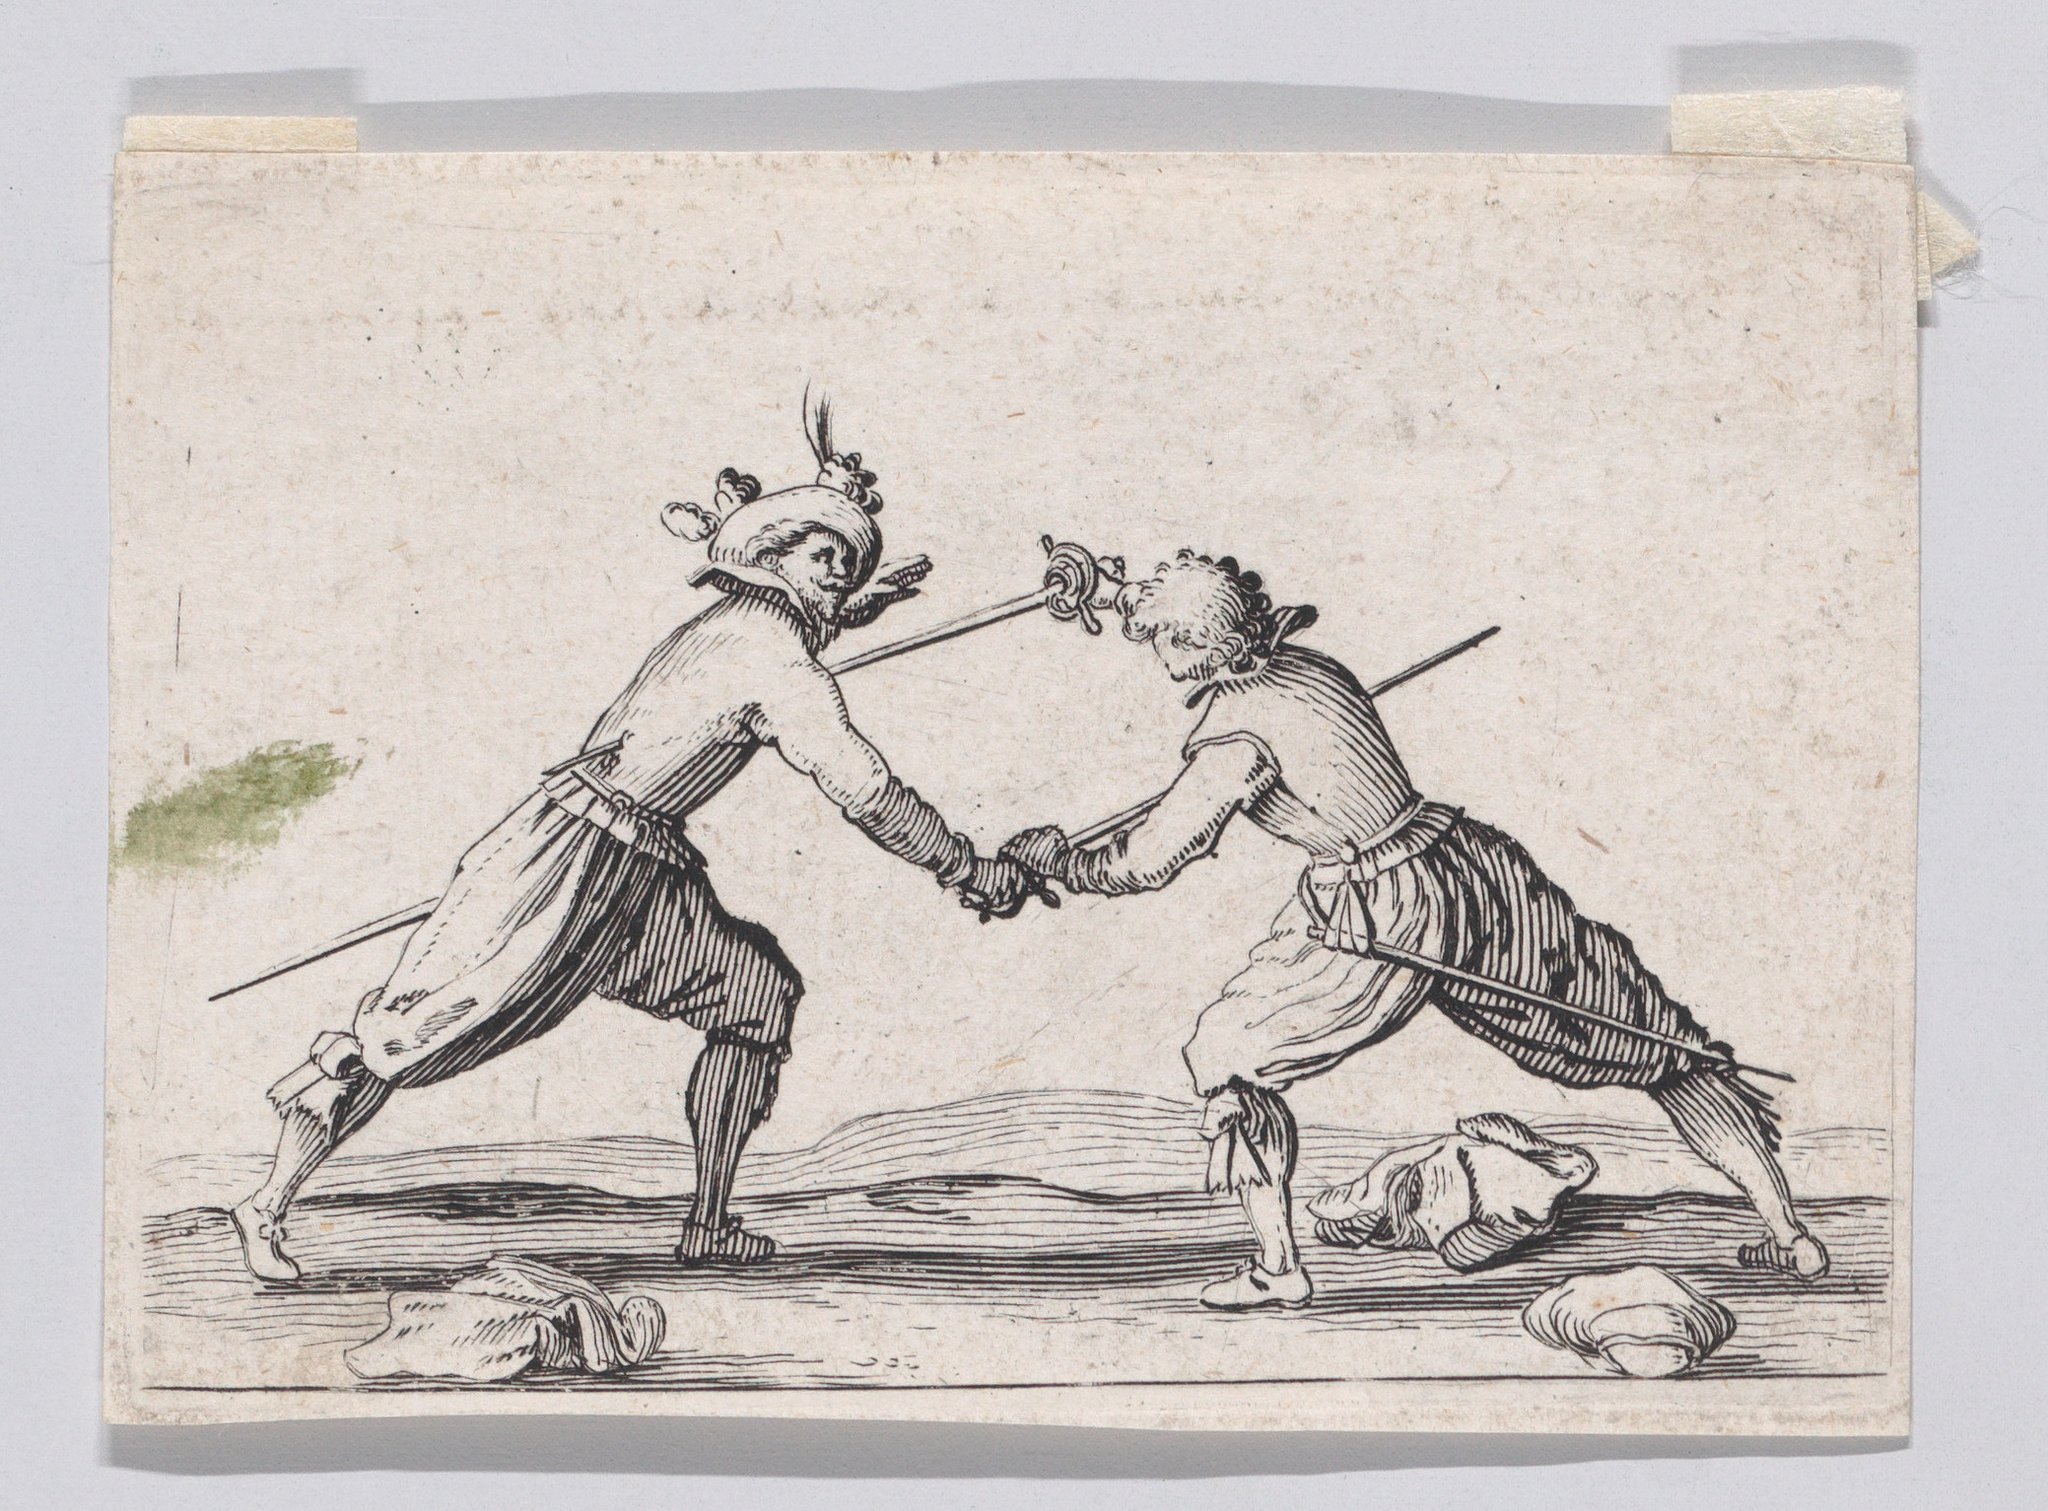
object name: print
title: Copy of Le Duel a L'Épée (The Duel with Swords), from "Les Caprices"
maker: Anonymous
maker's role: artist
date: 1601-1700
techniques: etching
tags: swords,men